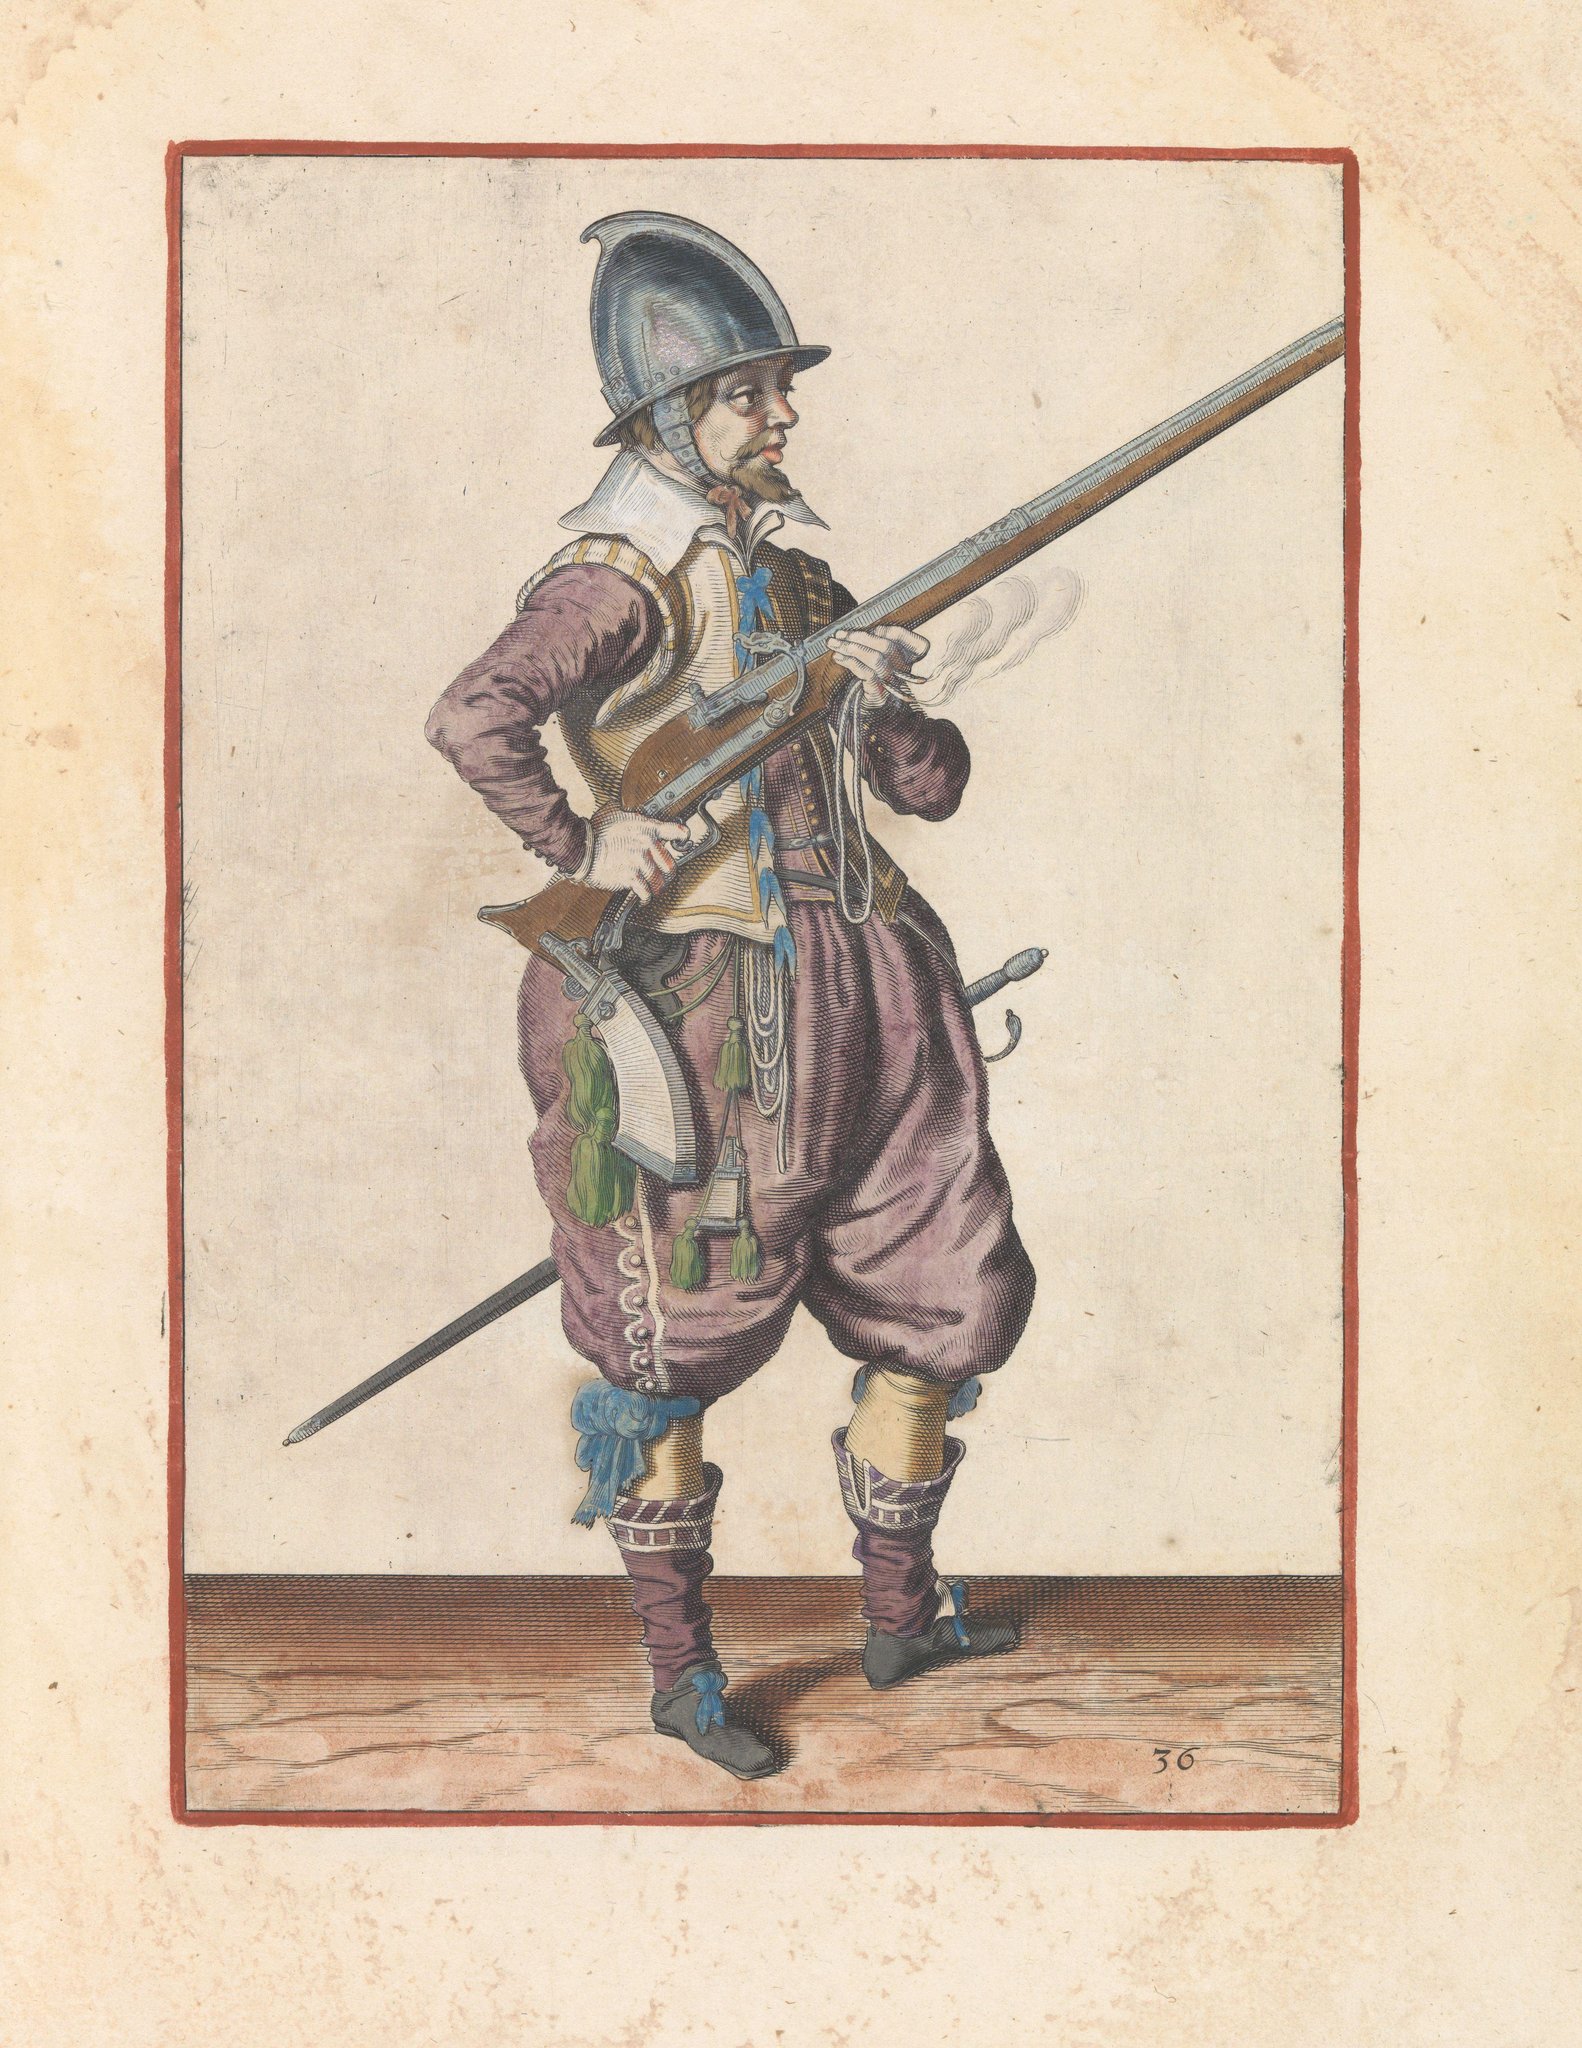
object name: print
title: Corte onderwysinghe op de figuerliicke afbeeldinghe, belanghende t'rechte ghebruyck des Roers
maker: jacques de gheyn (ii)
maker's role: painter, print maker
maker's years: 1565-1629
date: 1597-1607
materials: paper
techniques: engraving, hand coloring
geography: the hague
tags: handling of weapons ~ military training, firearms: rifle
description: Een soldaat op wacht, ten voeten uit, naar rechts, die een roer (een bepaald type vuurwapen) met beide handen bij zijn rechterzijde vasthoudt, zijn rechterwijsvinger aan de trekker, de loop schuin omhoog gericht. In zijn linkerhand behalve de loop van het roer ook een brandende lont. Deze prent is onderdeel van de reeks van 42 met de hand genummerde prenten van roerschutters in de Wapenhandelinghe. Op dit is exemplaar het nummer gedrukt.